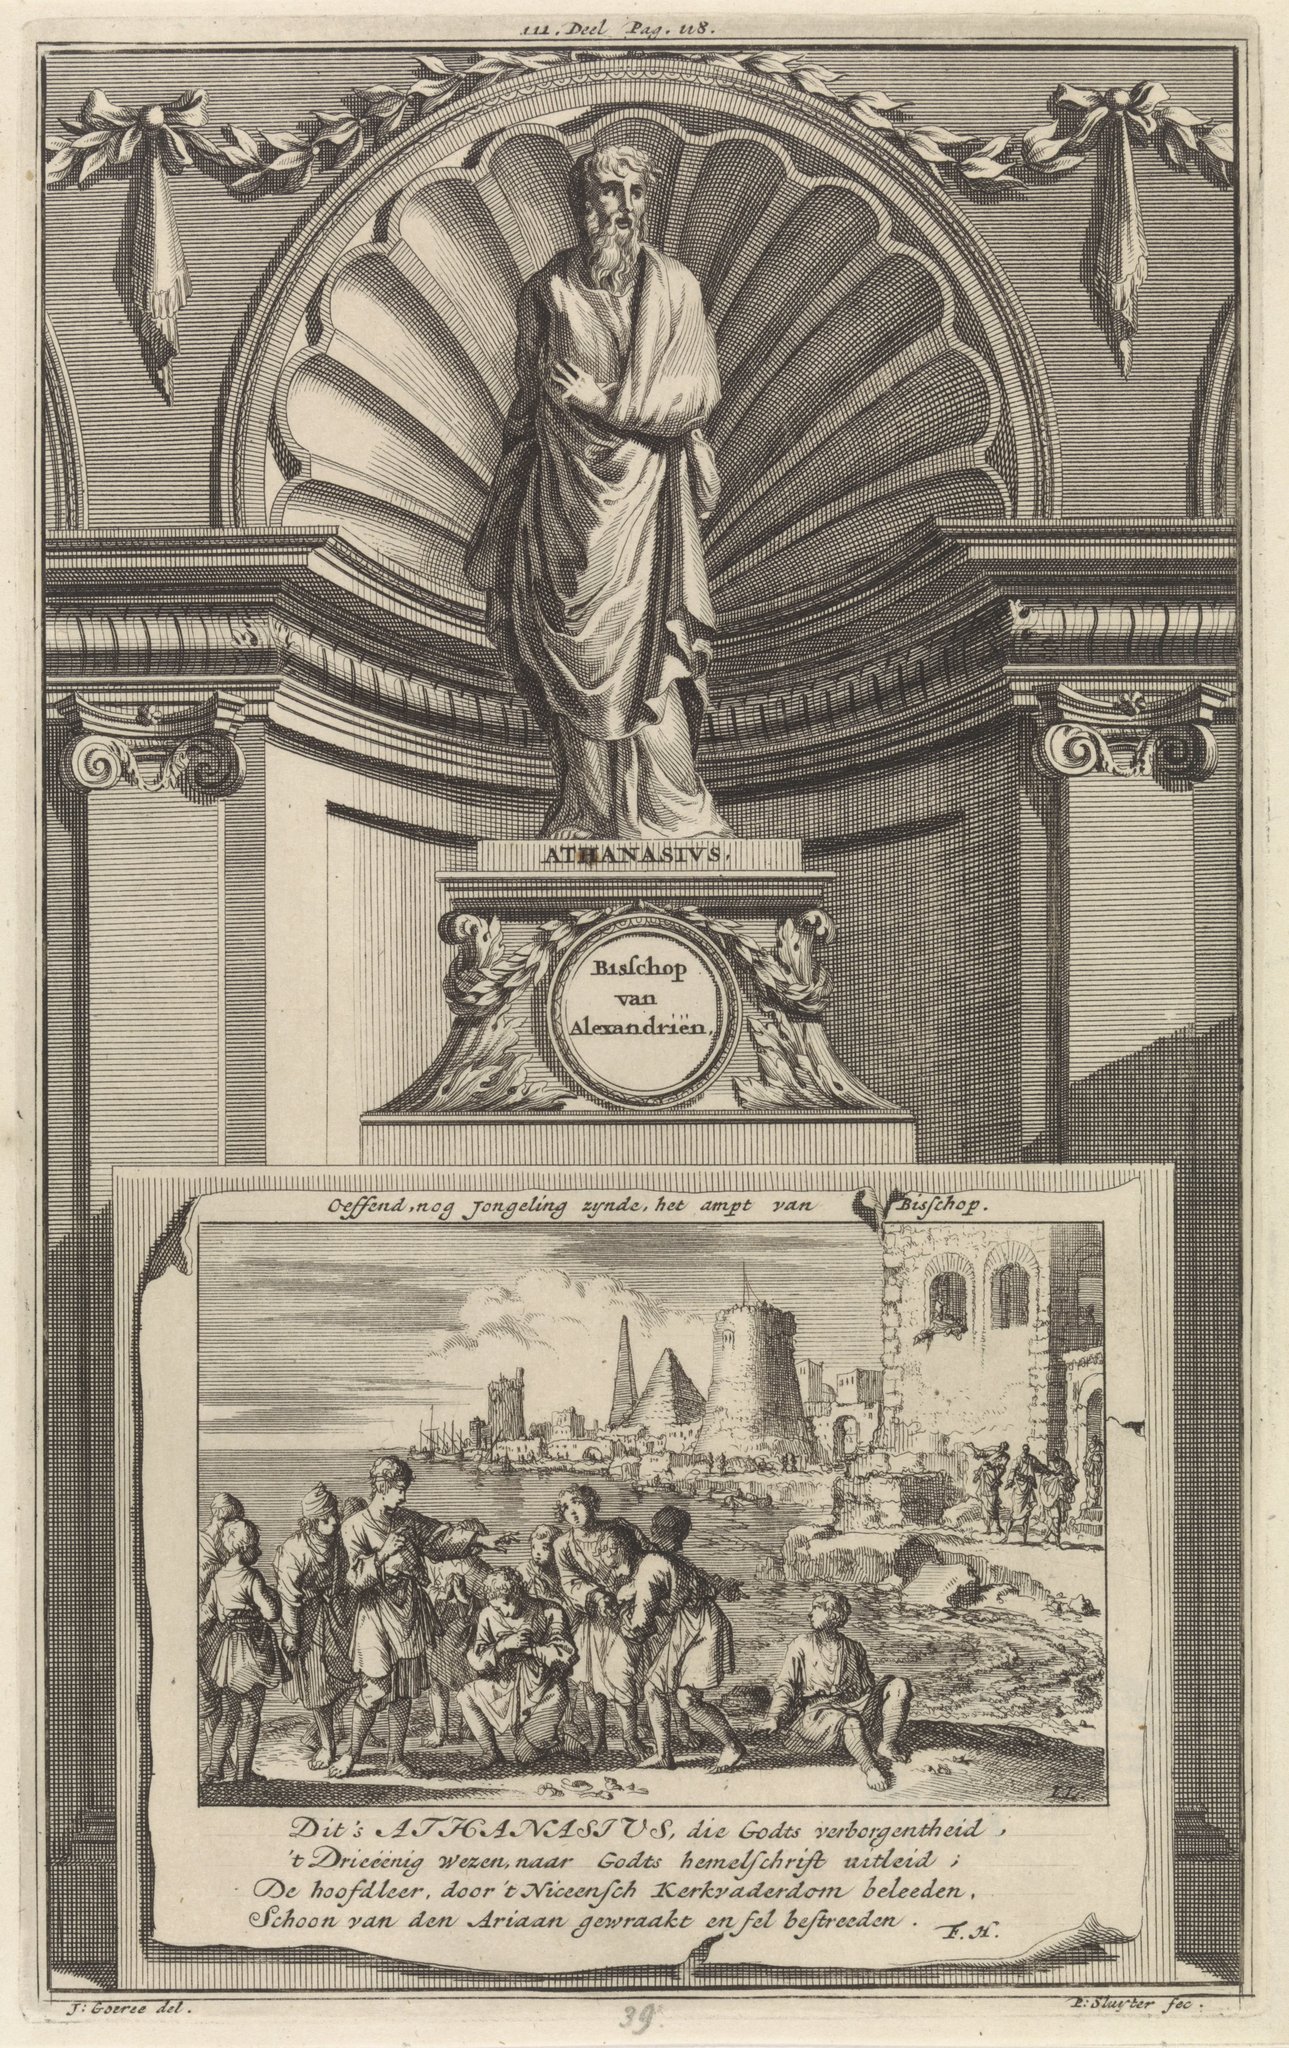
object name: book illustration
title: H. Athanasius van Alexandrië, kerkvader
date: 1698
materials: paper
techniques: engraving, etching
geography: amsterdam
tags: blessing (either of things or persons), e.g. by anointing, athanasius the great, bishop of alexandria; possible attributes: book, heretic under feet, scroll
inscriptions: collector's mark: Lugt 2228, number: ‘39’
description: De heilige kerkvader Athanasius van Alexandrië, staand op een sokkel. Op de voorzijde een scène waarin hij als jongetje andere kinderen zegend. Prent middenboven gemerkt: III. Deel Pag. 118.